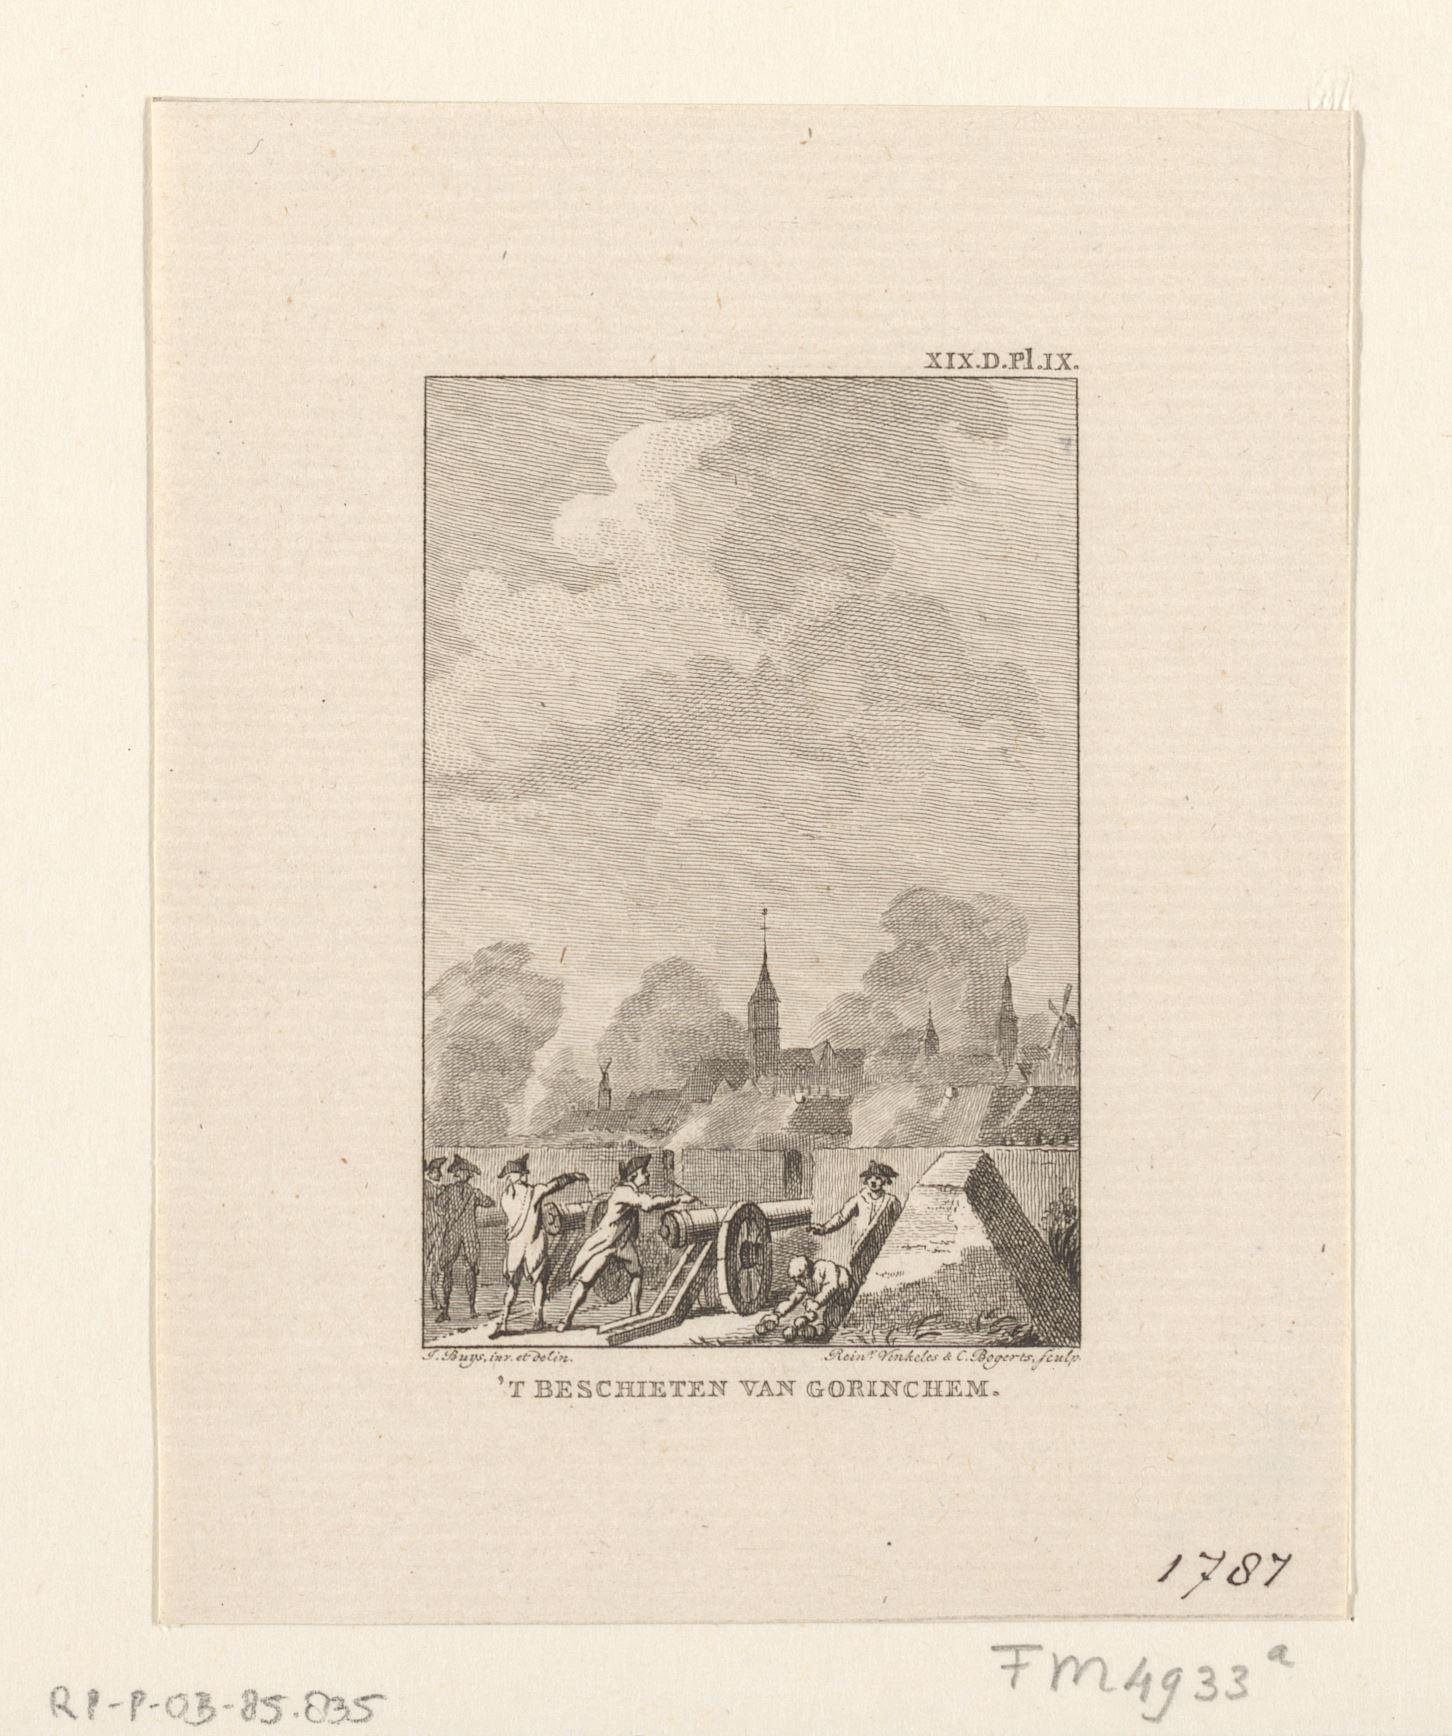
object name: print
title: Pruisen beschieten Gorinchem, 1787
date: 1787-1795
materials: paper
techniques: engraving, etching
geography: northern netherlands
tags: siege, position war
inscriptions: collector's mark: Lugt 2228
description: Gebruikt als illustratie in: J. Fokke, Geschiedenissen der Vereenigde Nederlanden voor de vaderlandsche jeugd, Johannes Allart, Amsterdam 1783-1795, 25 delen, dl. 19, pl. 9.